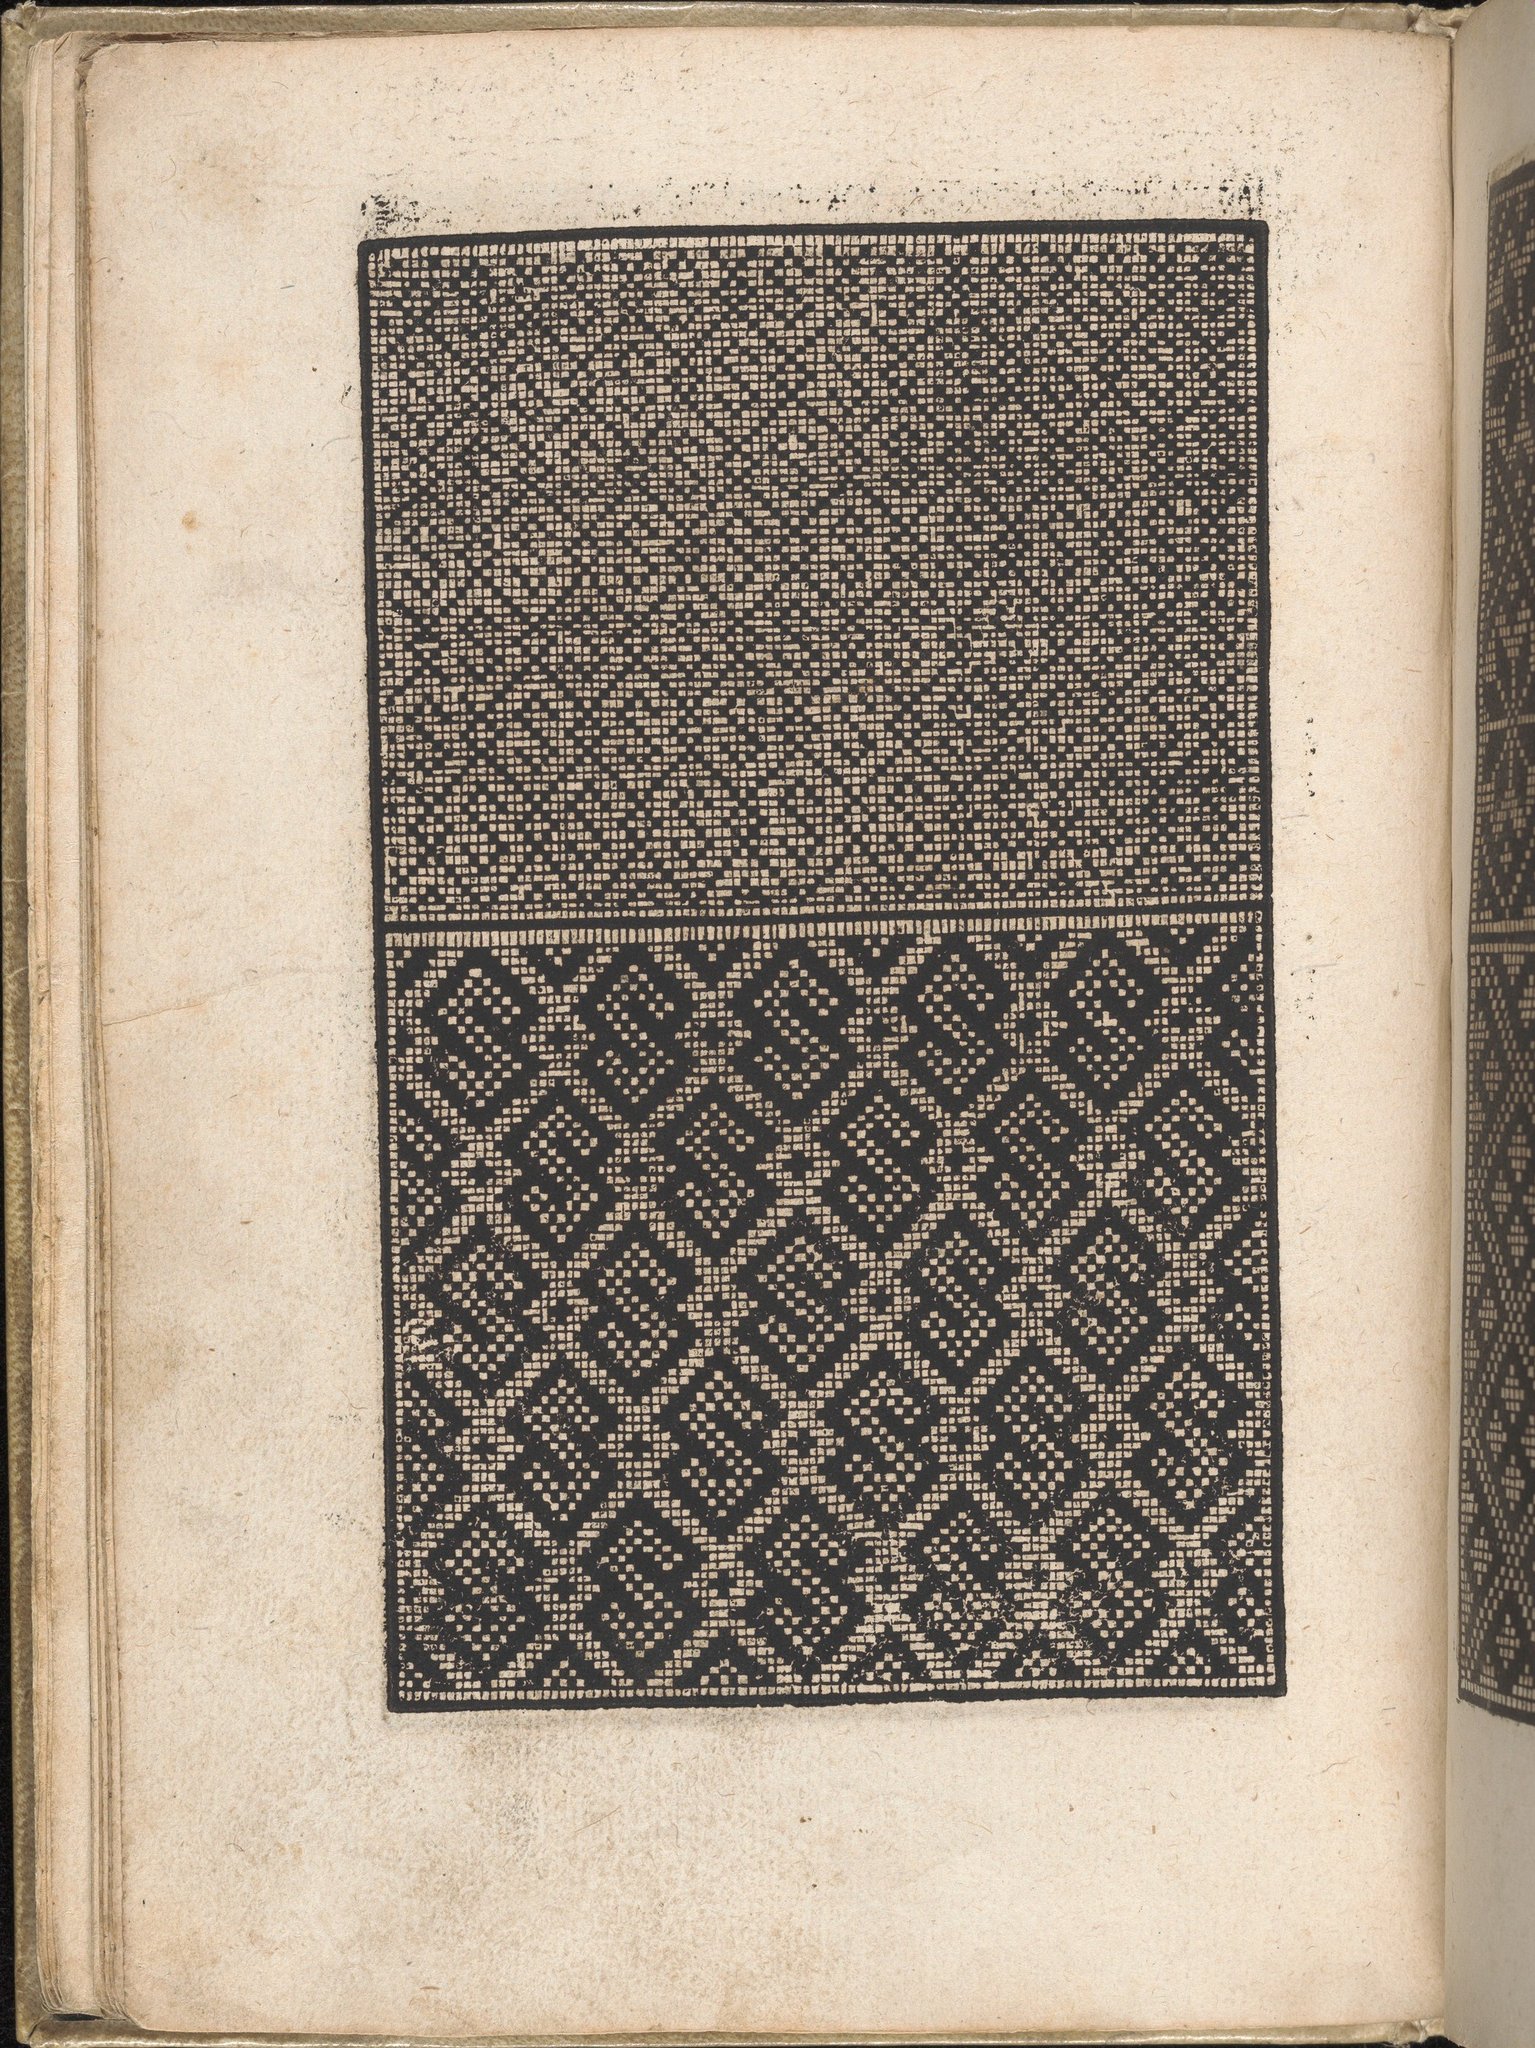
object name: book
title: Page 13v, from "Eyn New Kunstlichboich"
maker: peter quentel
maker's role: publisher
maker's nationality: german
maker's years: 1500-1550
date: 1529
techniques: woodcut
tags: ornament